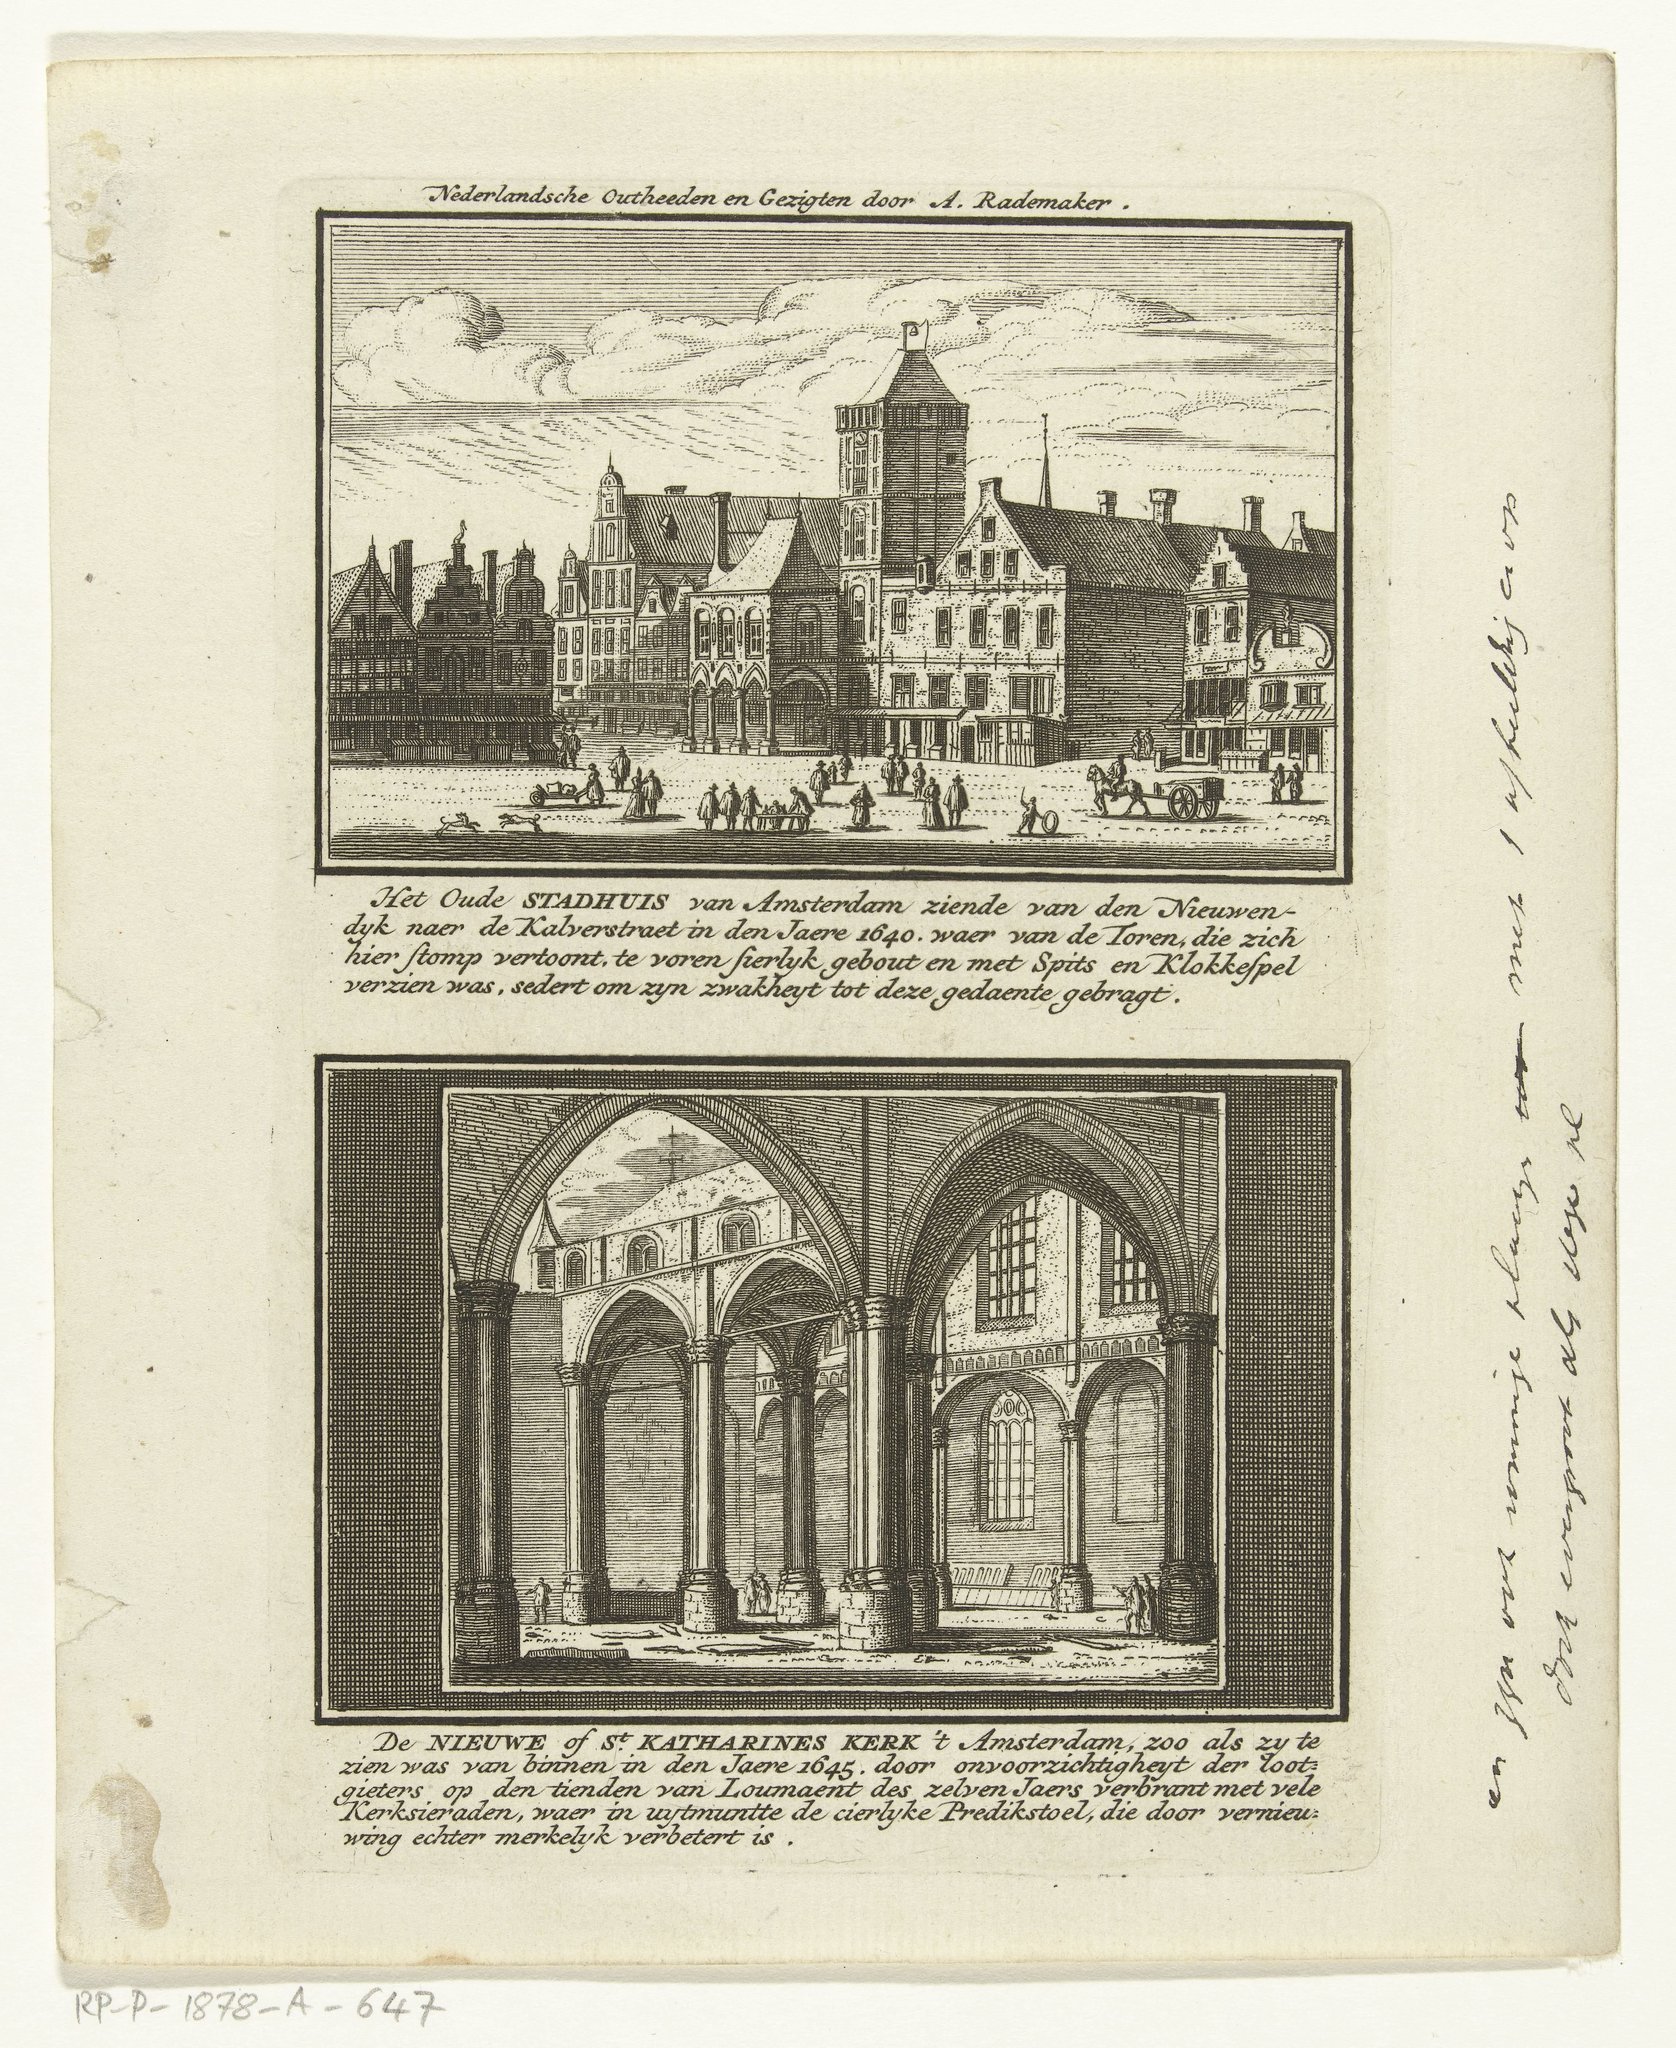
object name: print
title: Oude Stadhuis Amsterdam, 1640 en de Nieuwe Kerk Amsterdam, 1645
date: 1726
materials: paper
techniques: etching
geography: amsterdam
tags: nieuwe kerk, stadhuis van amsterdam (14e eeuw-1652)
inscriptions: collector's mark: Lugt 2228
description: Bladzijde uit 'Versameling van 100. Nederlantse Outheden en Gesigten'. Boven een afbeelding van het oude Stadhuis van Amsterdam uit 1640, onder een afbeelding van het interieur van de Nieuwe Kerk voor de grote brand in 1645.